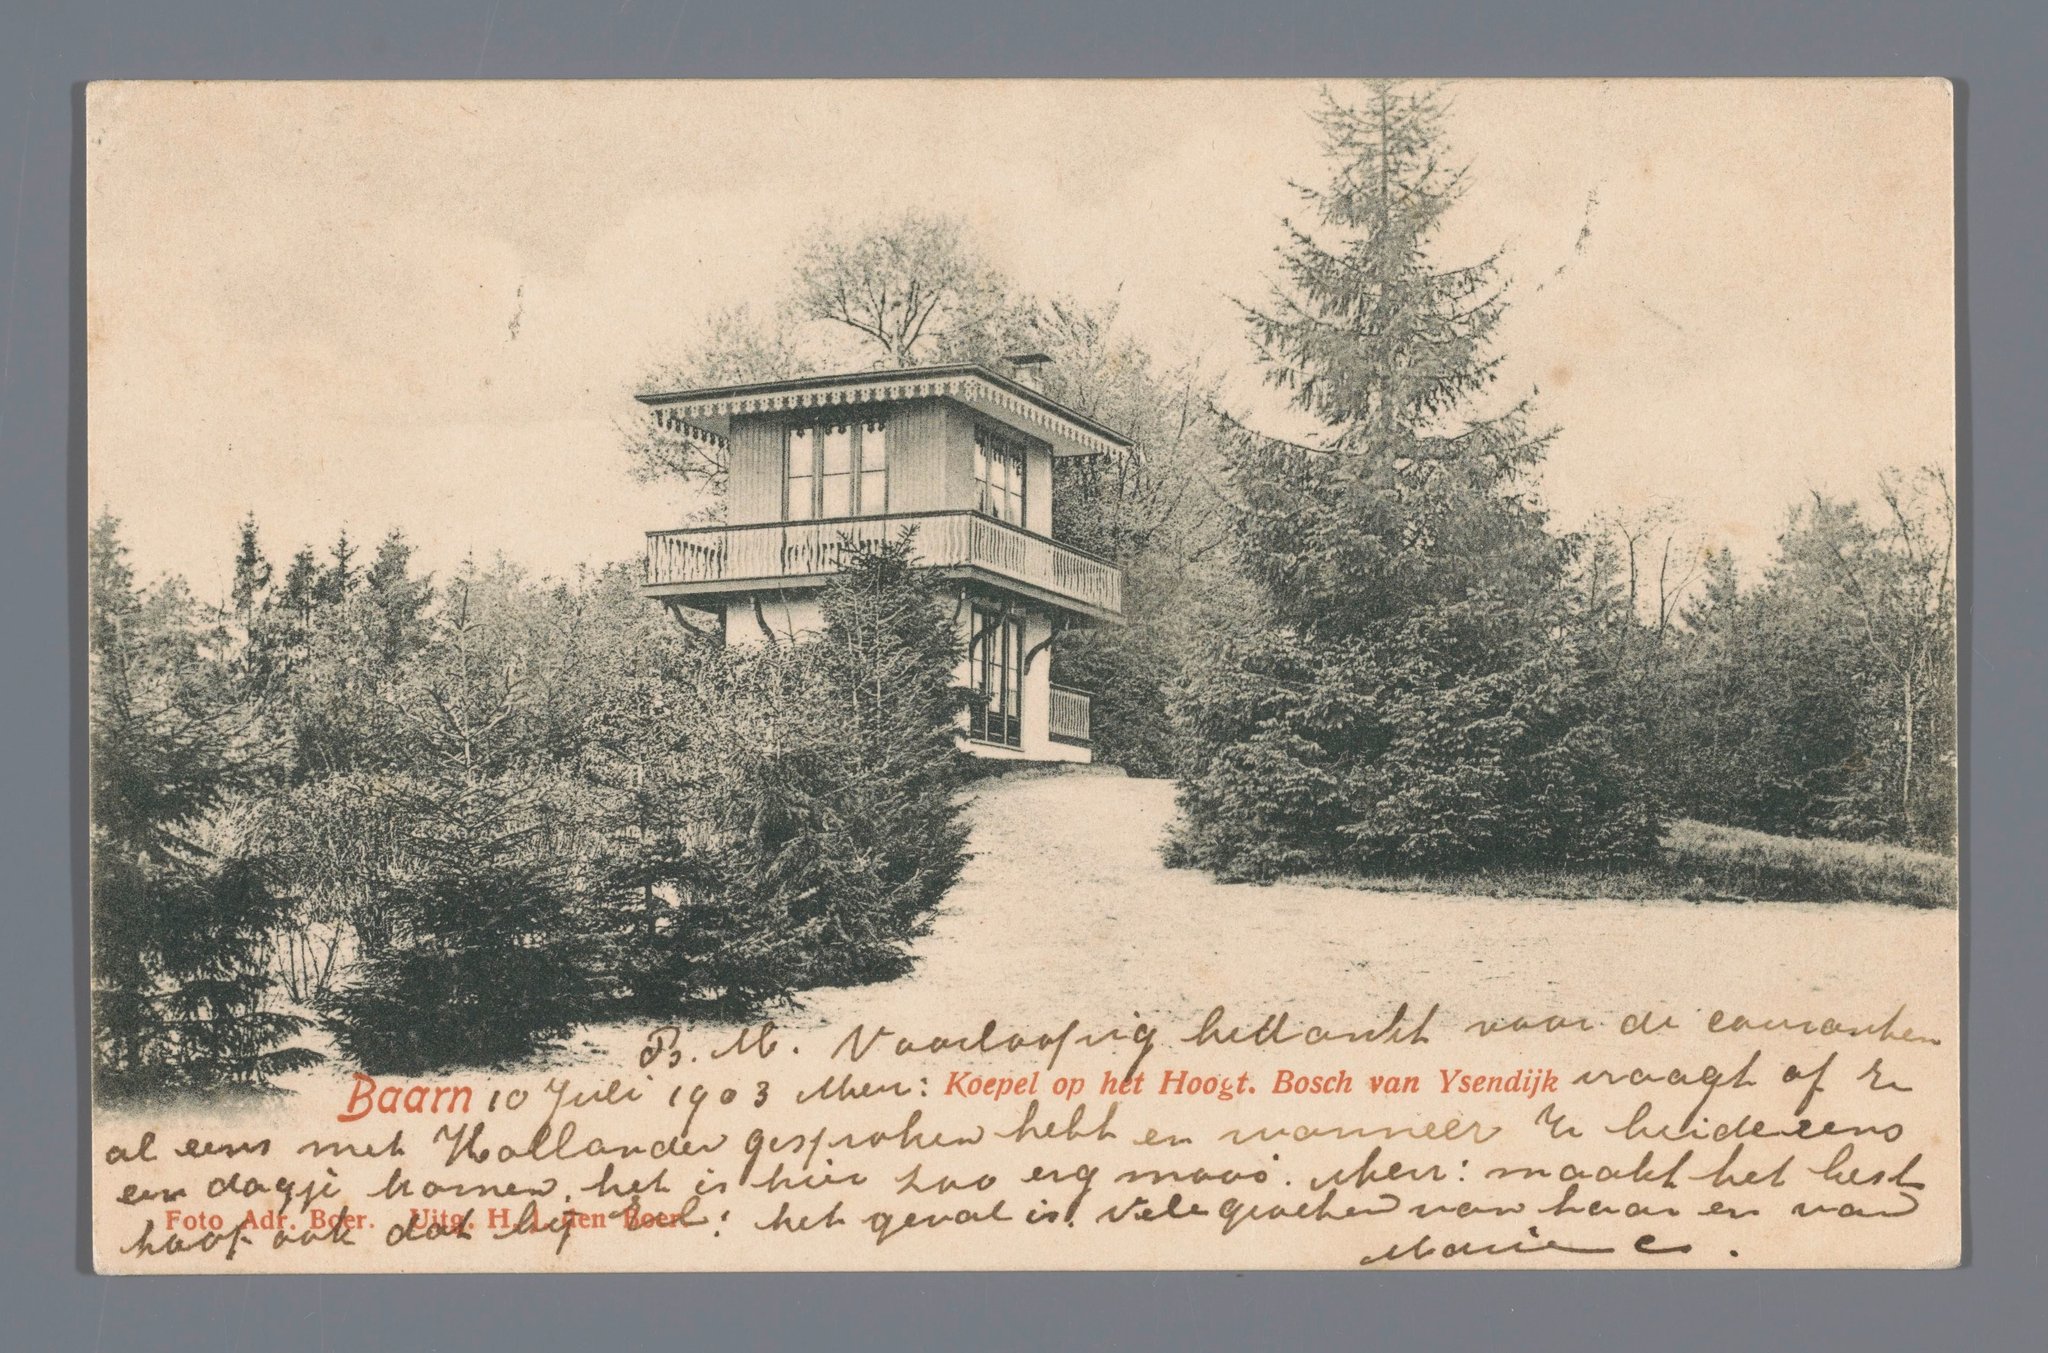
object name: ansichtkaart, prentbriefkaart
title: Koepel op het Hoogt, Ysendijk, Baarn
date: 1903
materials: paper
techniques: photograph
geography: baarn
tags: dome ~ architecture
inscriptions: inscription: ‘Baarn Koepel op het Hoogt. Bosch van Ysendijk / Foto Adr. Boer. Uitg. H.[.] den Boer’, annotation: ‘10 juli 1903 (...) Voorloopig (?) bedankt voor de (...)vraagh of ze al eens met Hollander gesproken hebt en wanneer ze (...)’, address: ‘Mevrouw A Split Pieneman / Bleekersingel / Gouda’